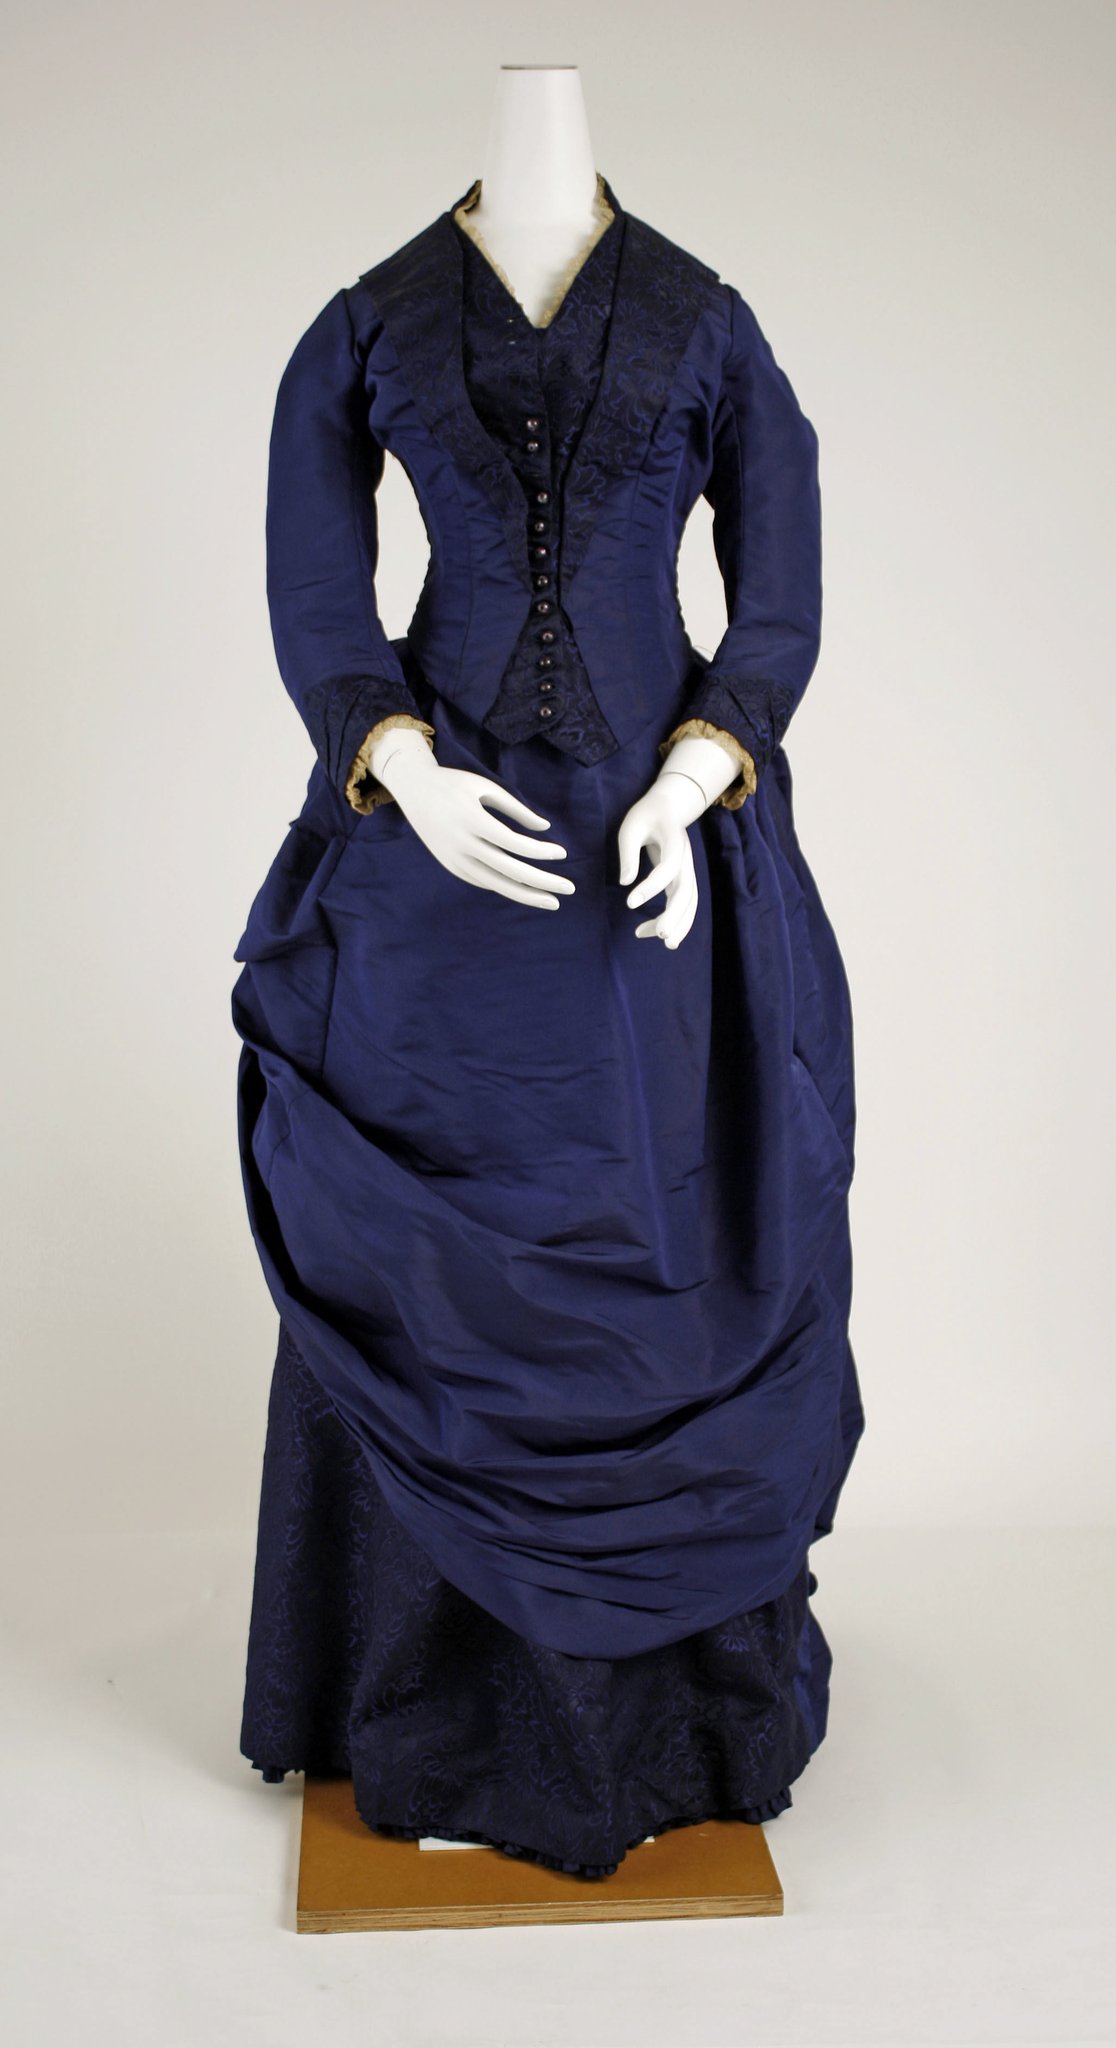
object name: dress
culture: french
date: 1886